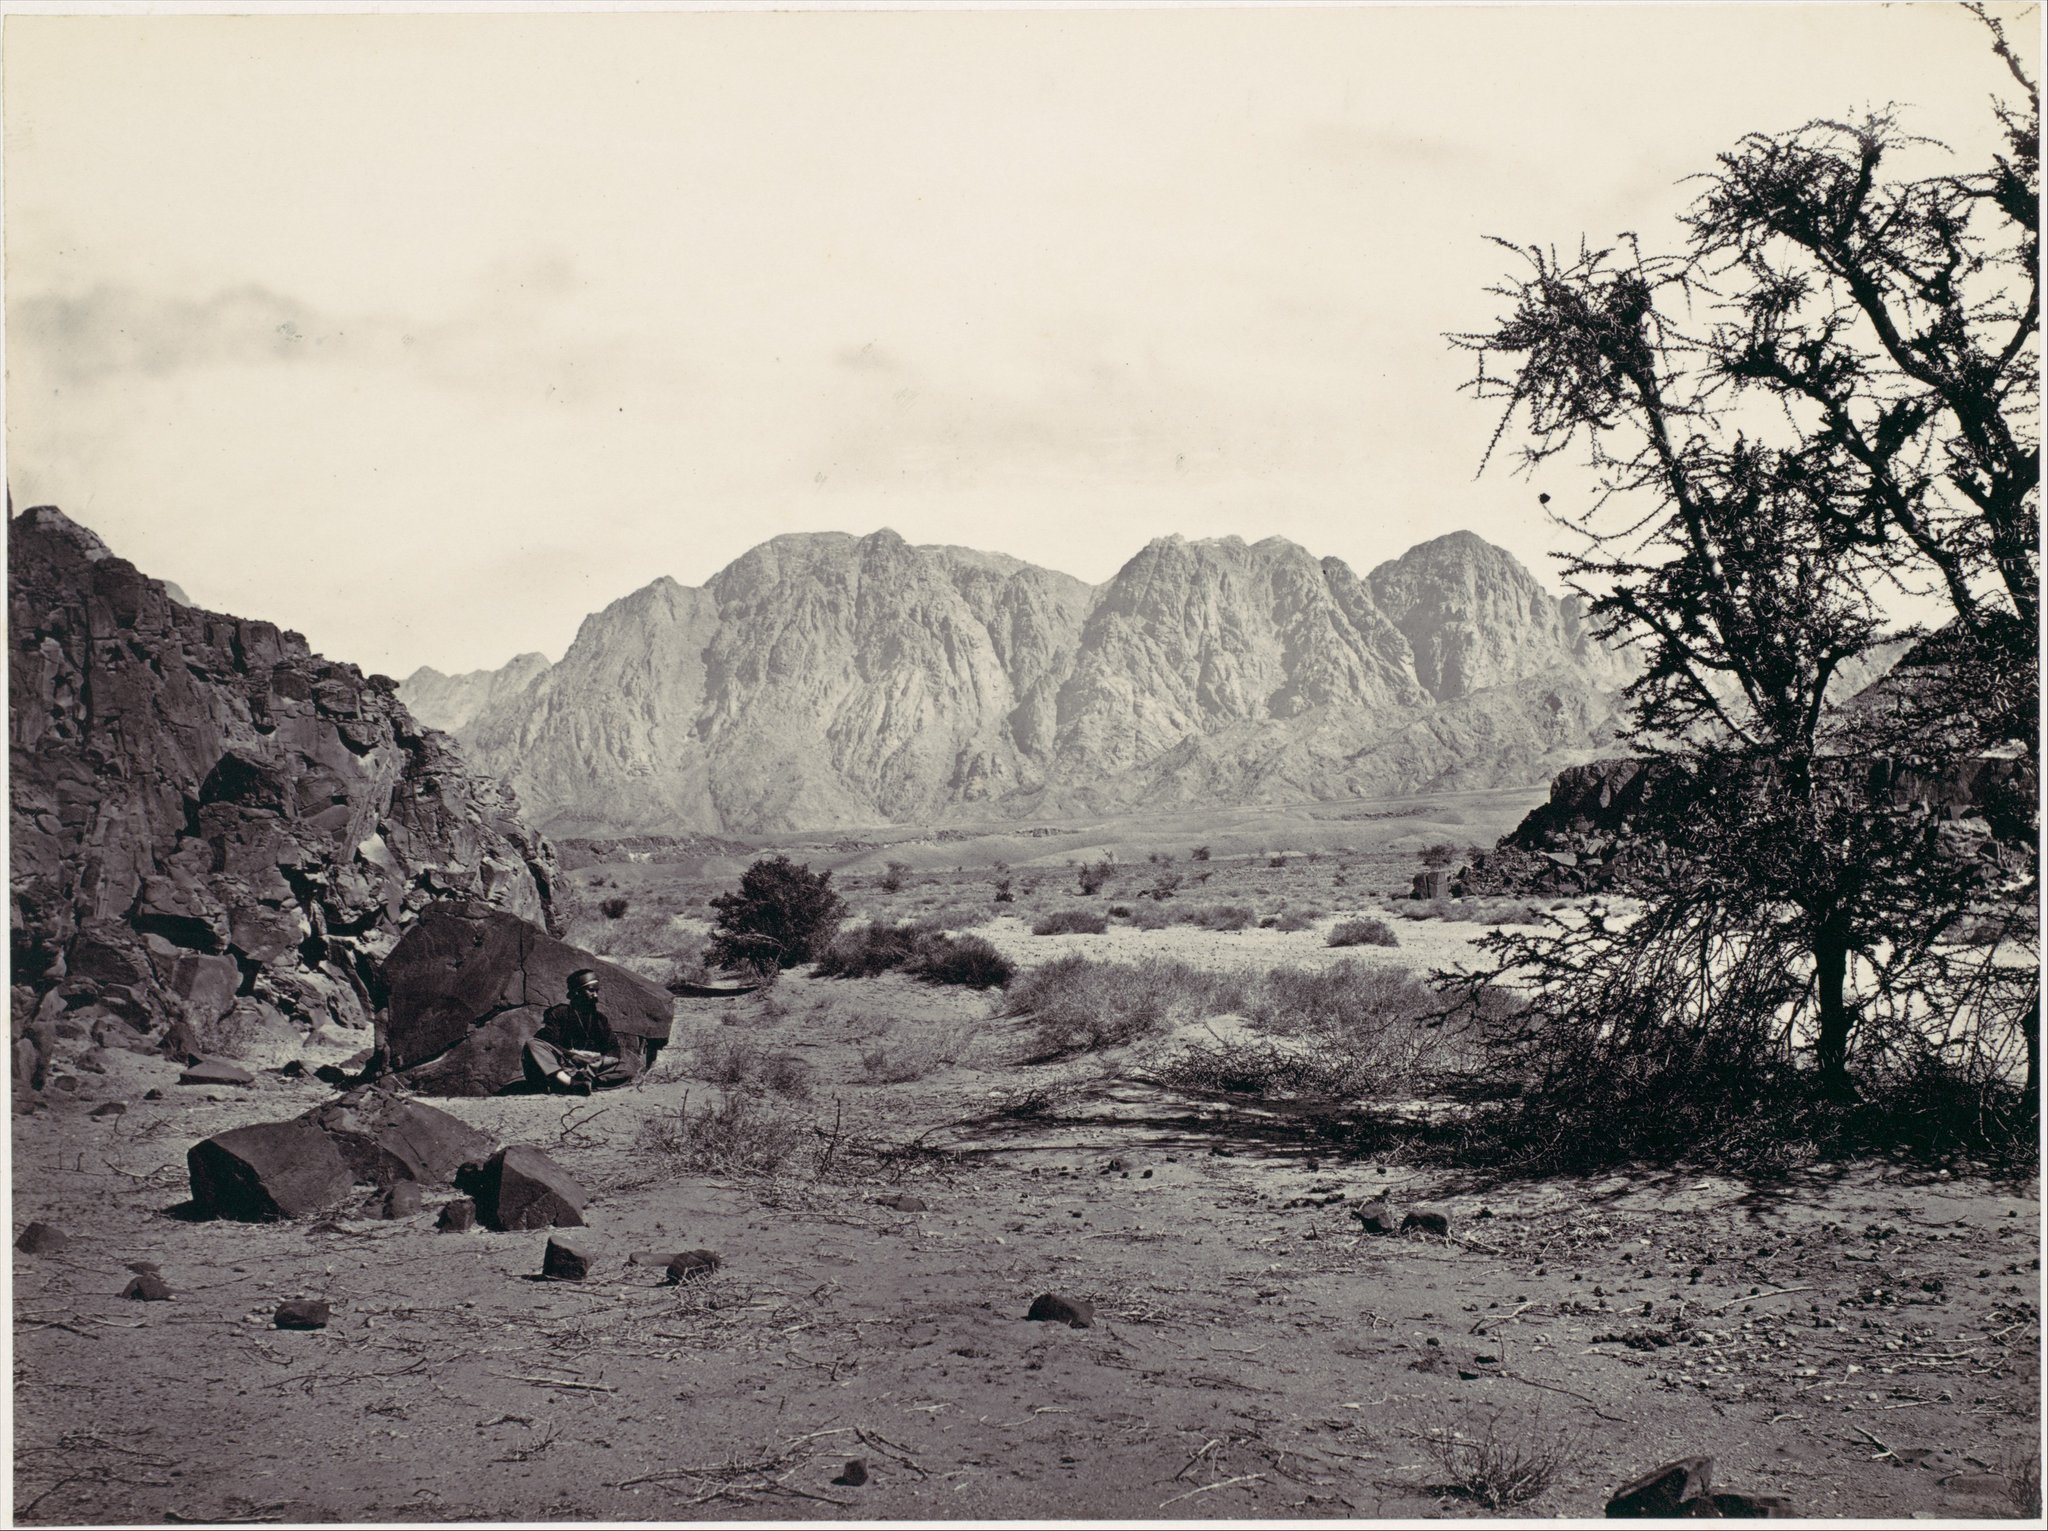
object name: photograph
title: The Written Valley, Sinai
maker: francis frith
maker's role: publisher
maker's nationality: english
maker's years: 1822-1898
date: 1857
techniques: albumen silver print, glass negative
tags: mountains,landscapes